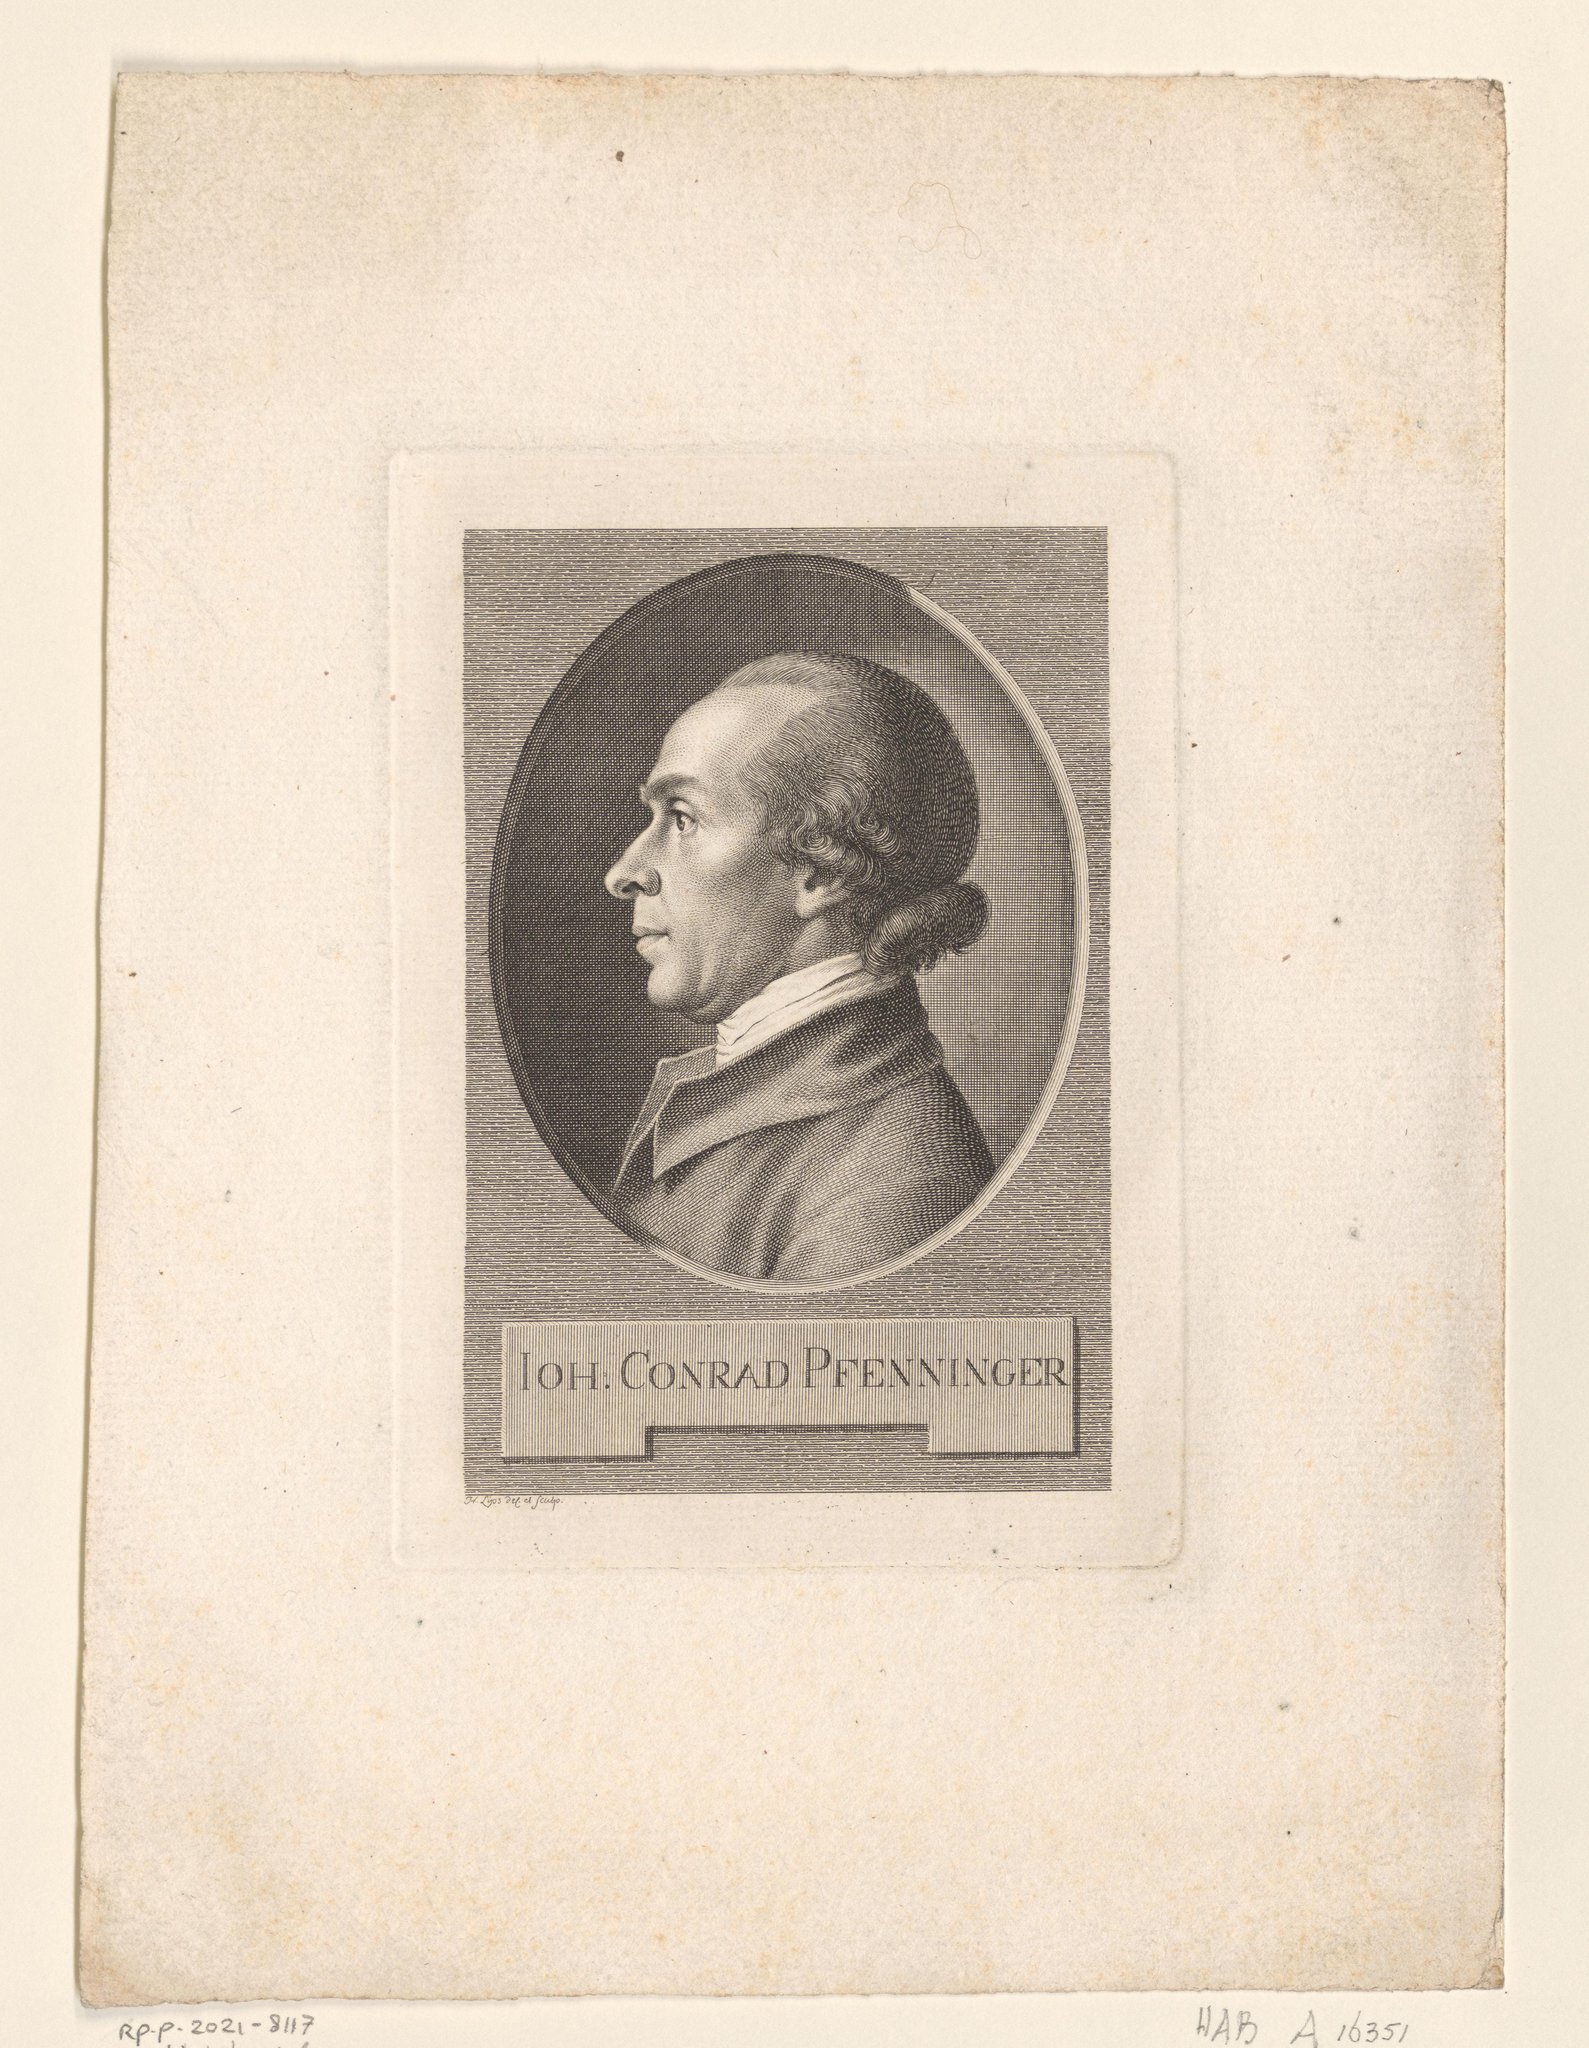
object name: print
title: Portret van Johann Konrad Pfenninger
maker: johann heinrich lips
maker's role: draughtsman, painter, print maker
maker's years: 1758-1817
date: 1768-1817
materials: paper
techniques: engraving, etching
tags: adult man, historical persons